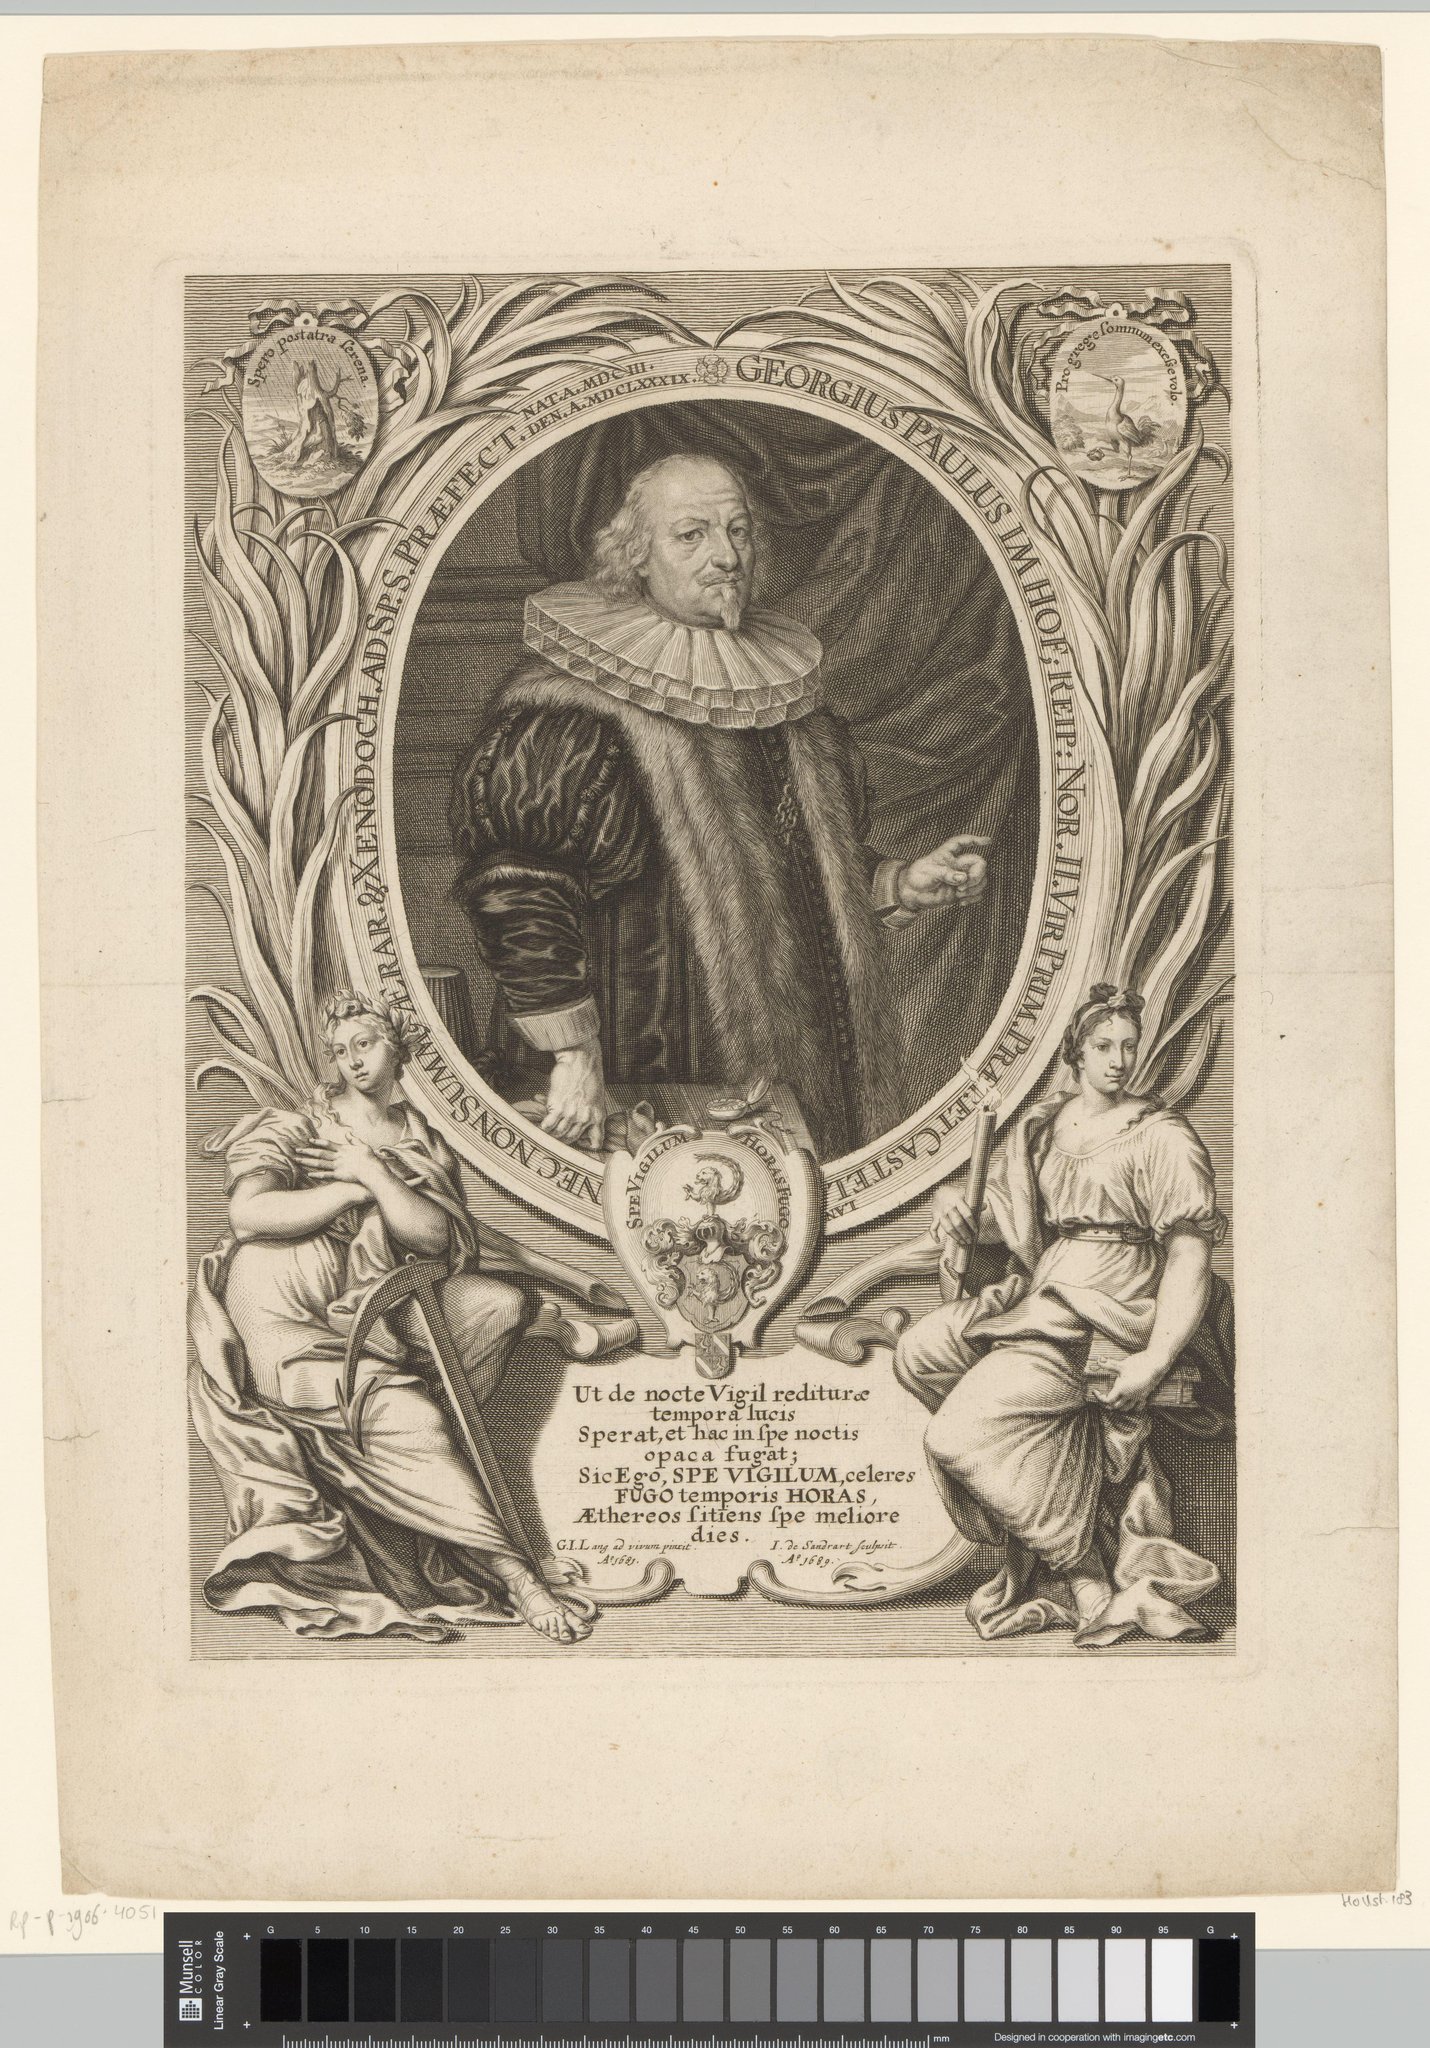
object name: print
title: Portret van Georg Paul Imhof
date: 1640-1708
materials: paper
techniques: engraving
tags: mayor, historical persons, abstract ideas and concepts (+ emblematical representation of concept), watch, armorial bearing, heraldry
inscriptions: collector's mark: Lugt 2228